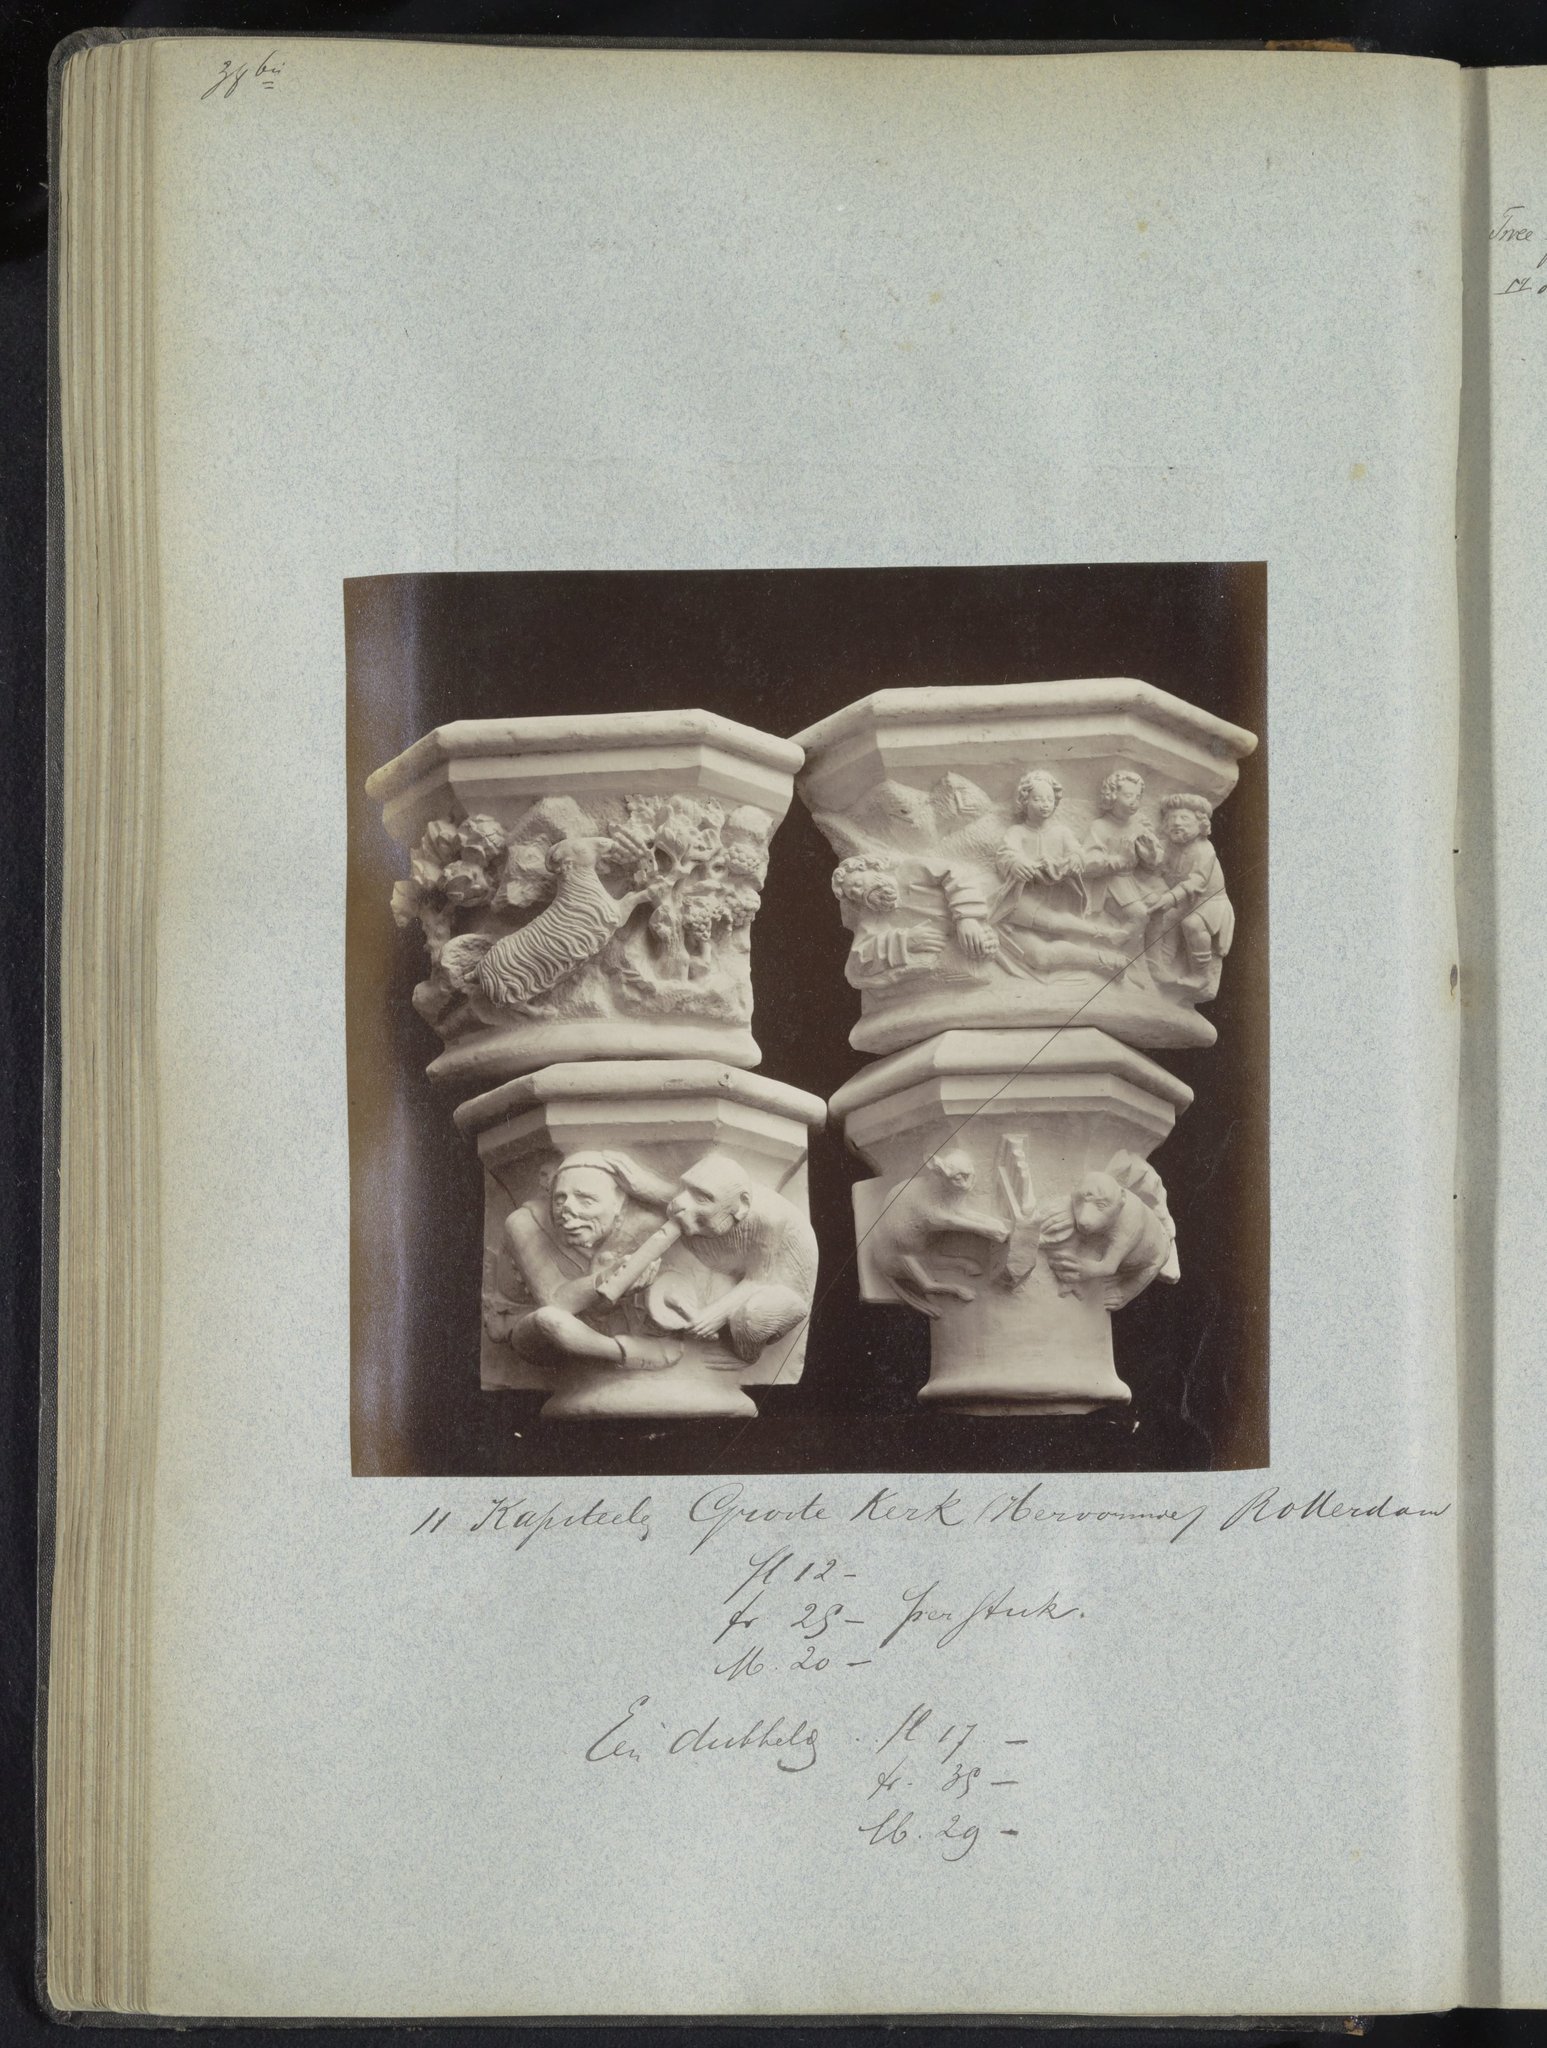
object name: photograph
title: Twee afgietsels van kapitelen uit de Grote Kerk te Rotterdam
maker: Anonymous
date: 1875-1900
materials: paper, photographic support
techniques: albumen print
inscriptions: annotation, annotation: ‘11 Kapitelen Groote Kerk (hervormde) Rotterdam’